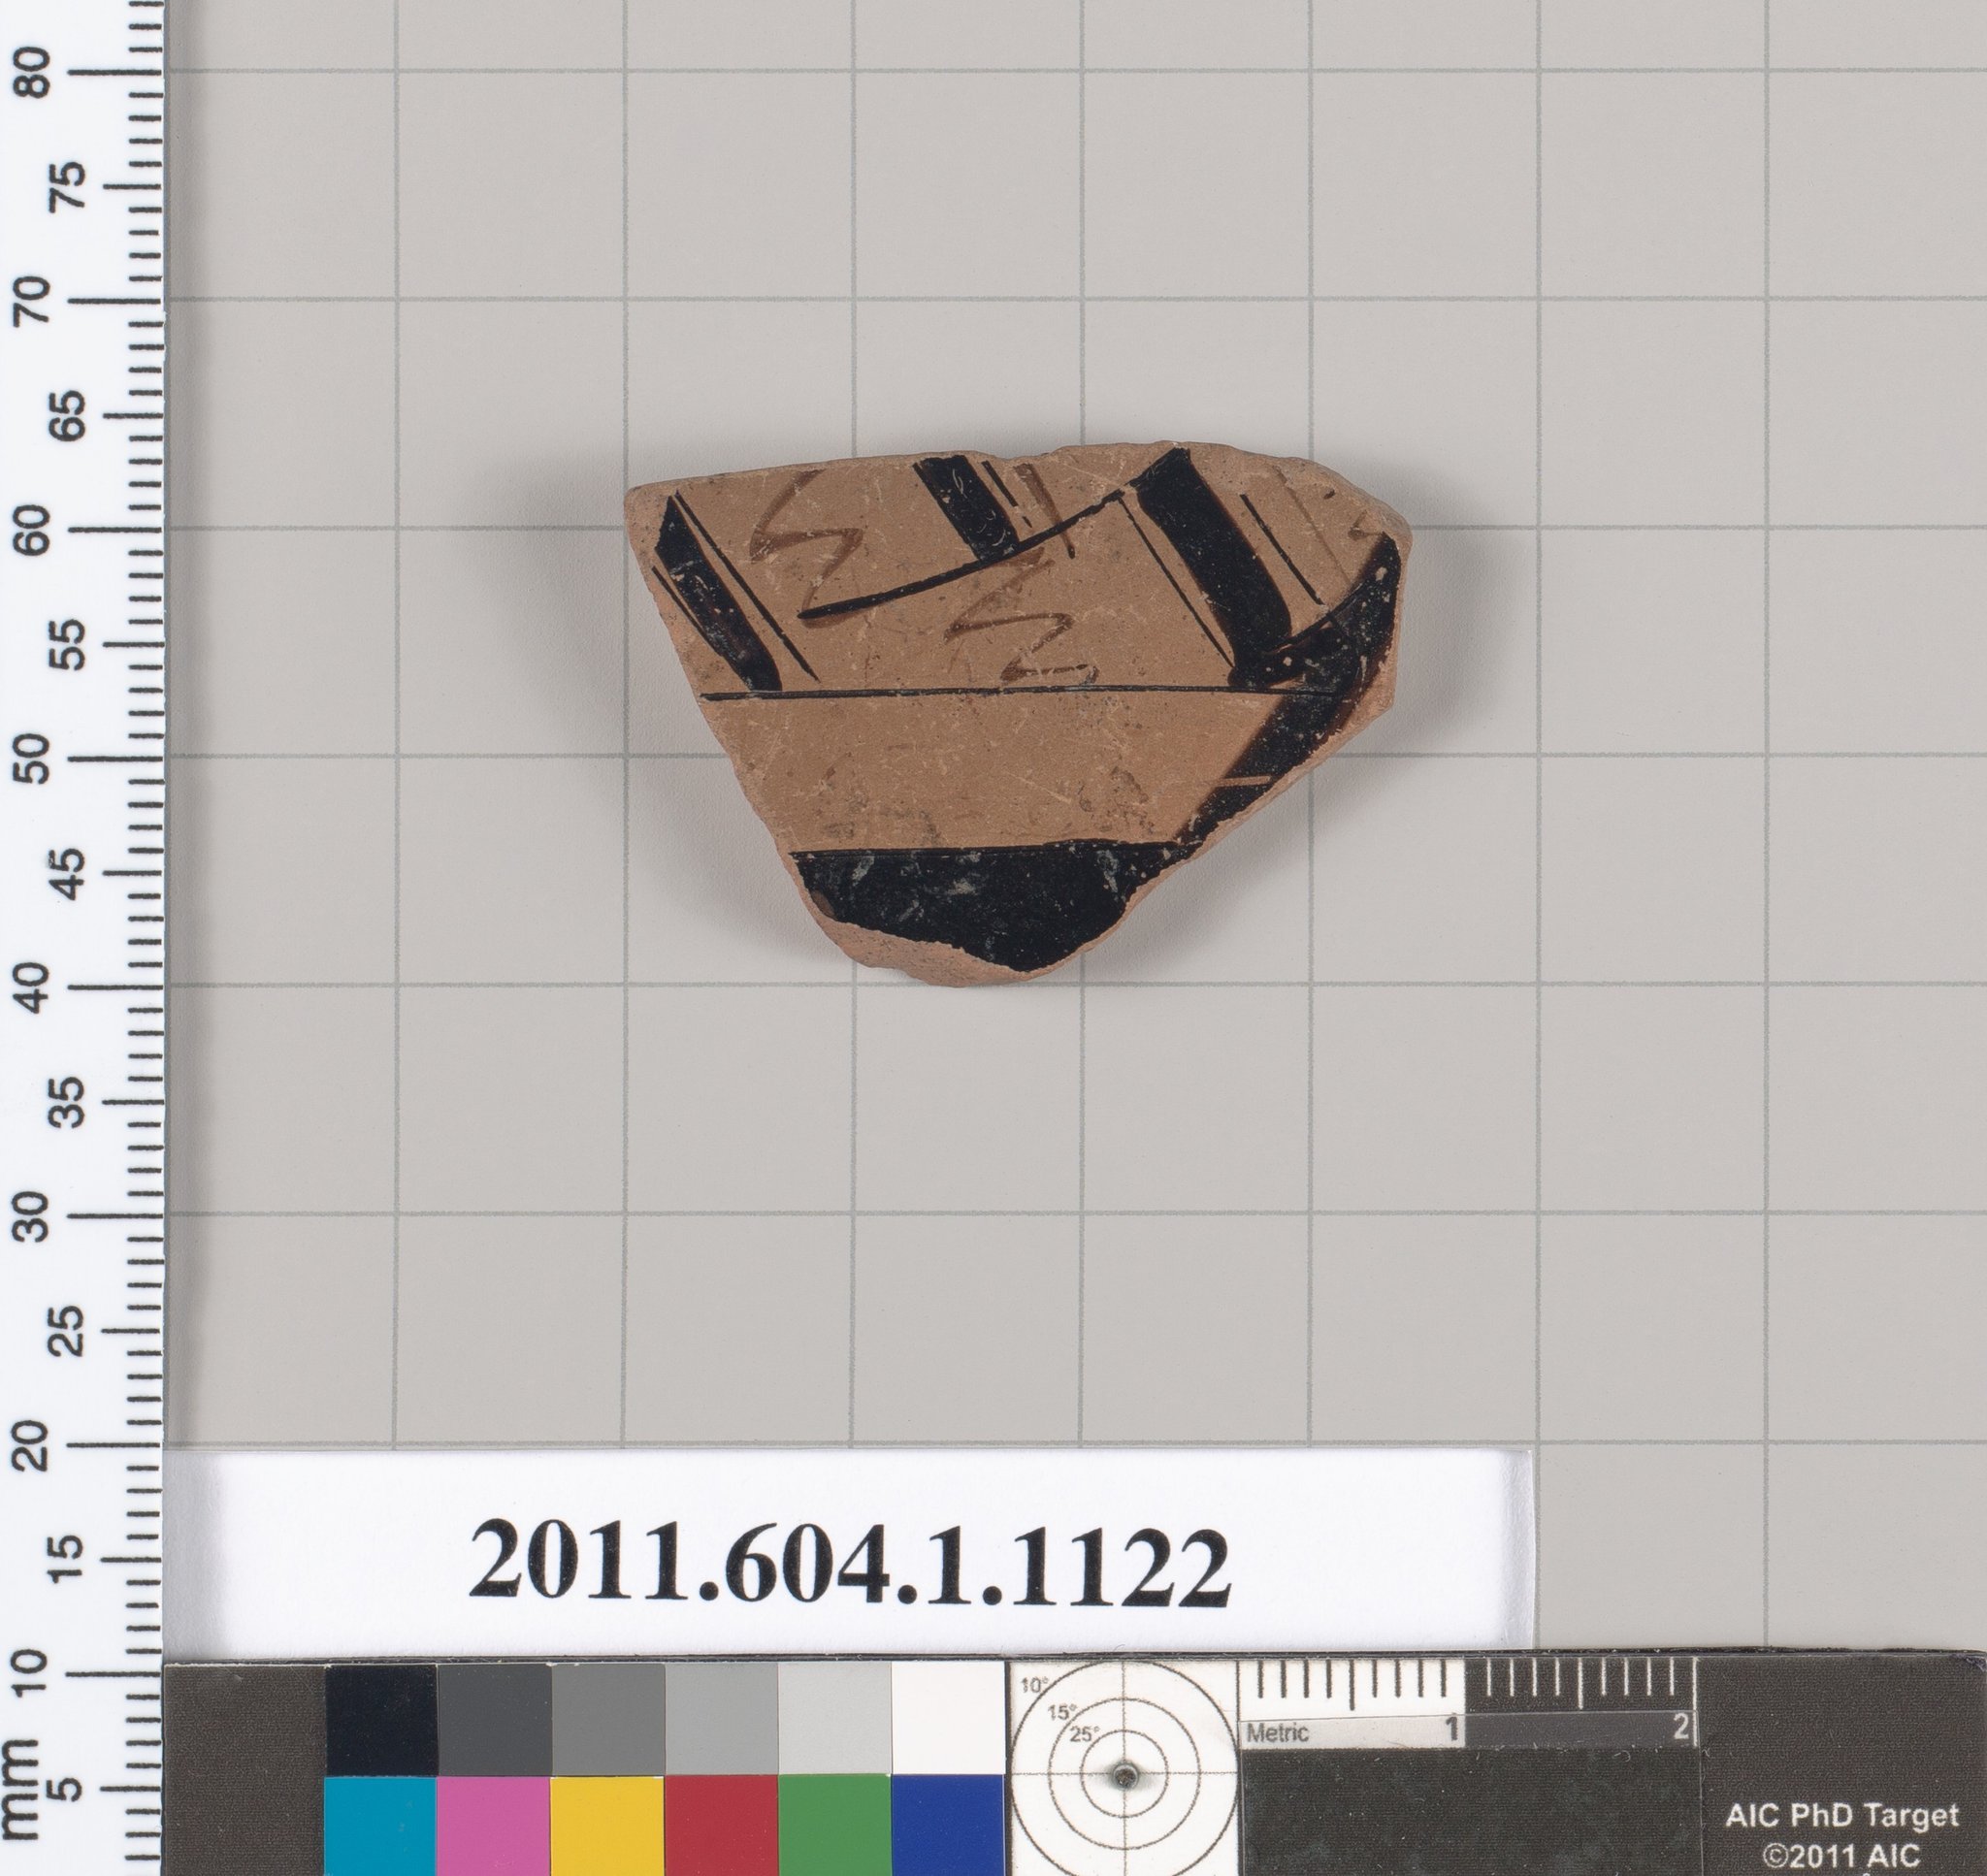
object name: kylix fragment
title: Terracotta fragment of a kylix (drinking cup)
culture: greek, attic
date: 500-451 BCE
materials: terracotta